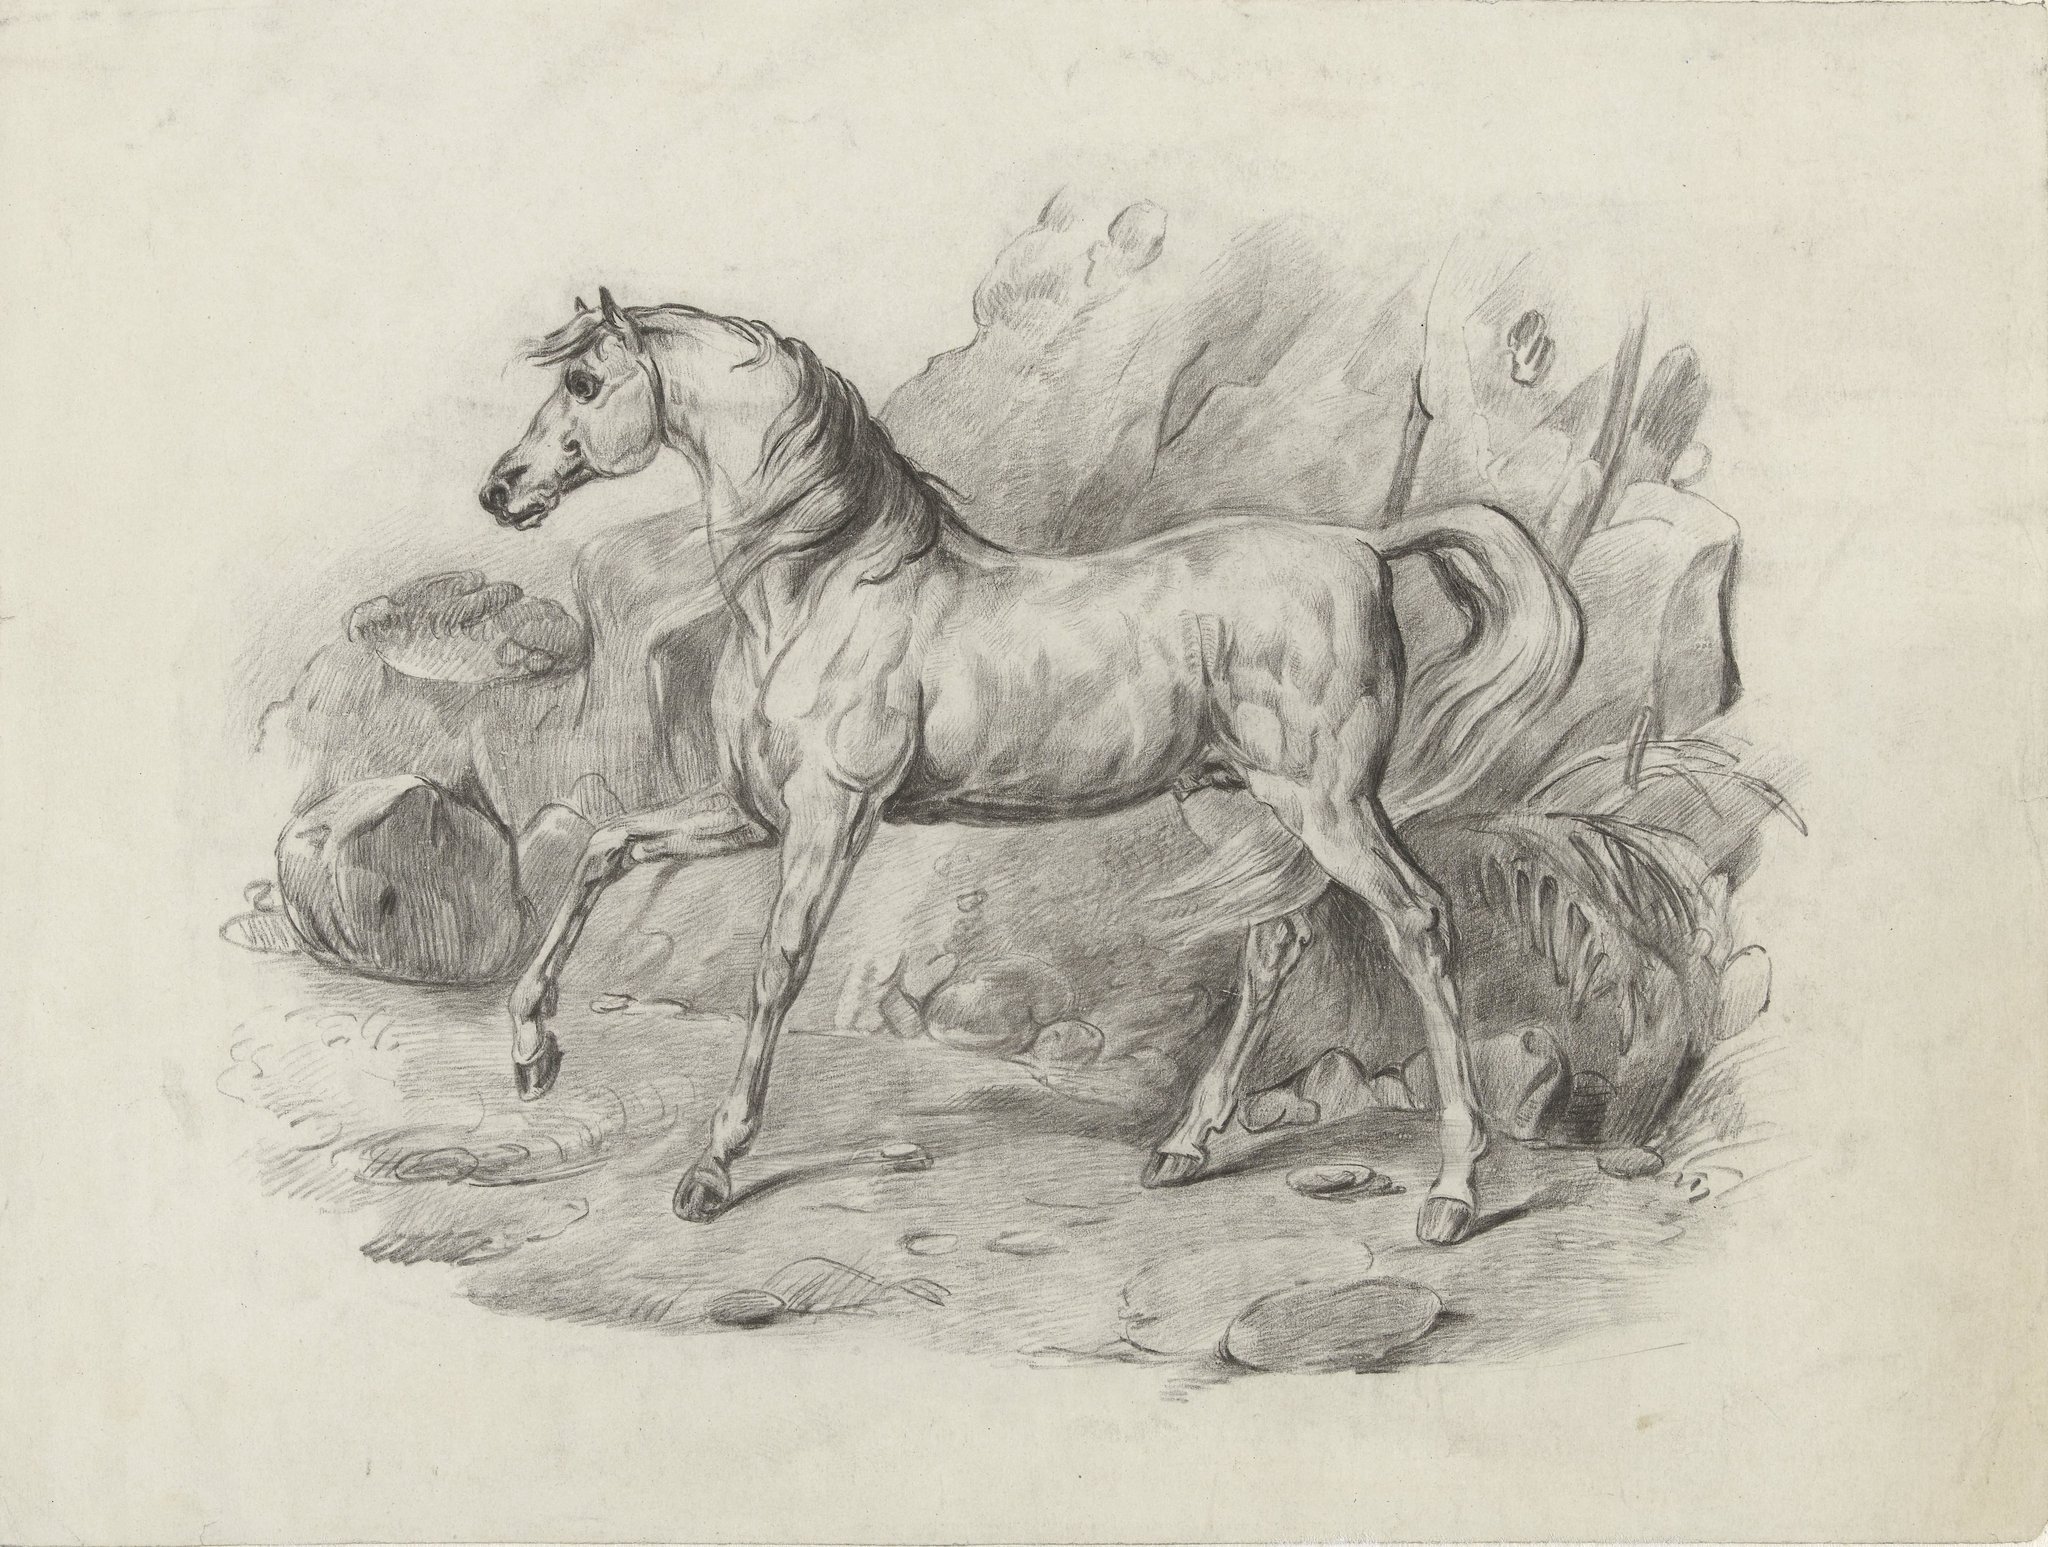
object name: drawing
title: Staand paard, naar links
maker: george hendrik breitner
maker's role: draughtsman, painter, print maker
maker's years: 1857-1923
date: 1867-1923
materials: chalk, paper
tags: horse